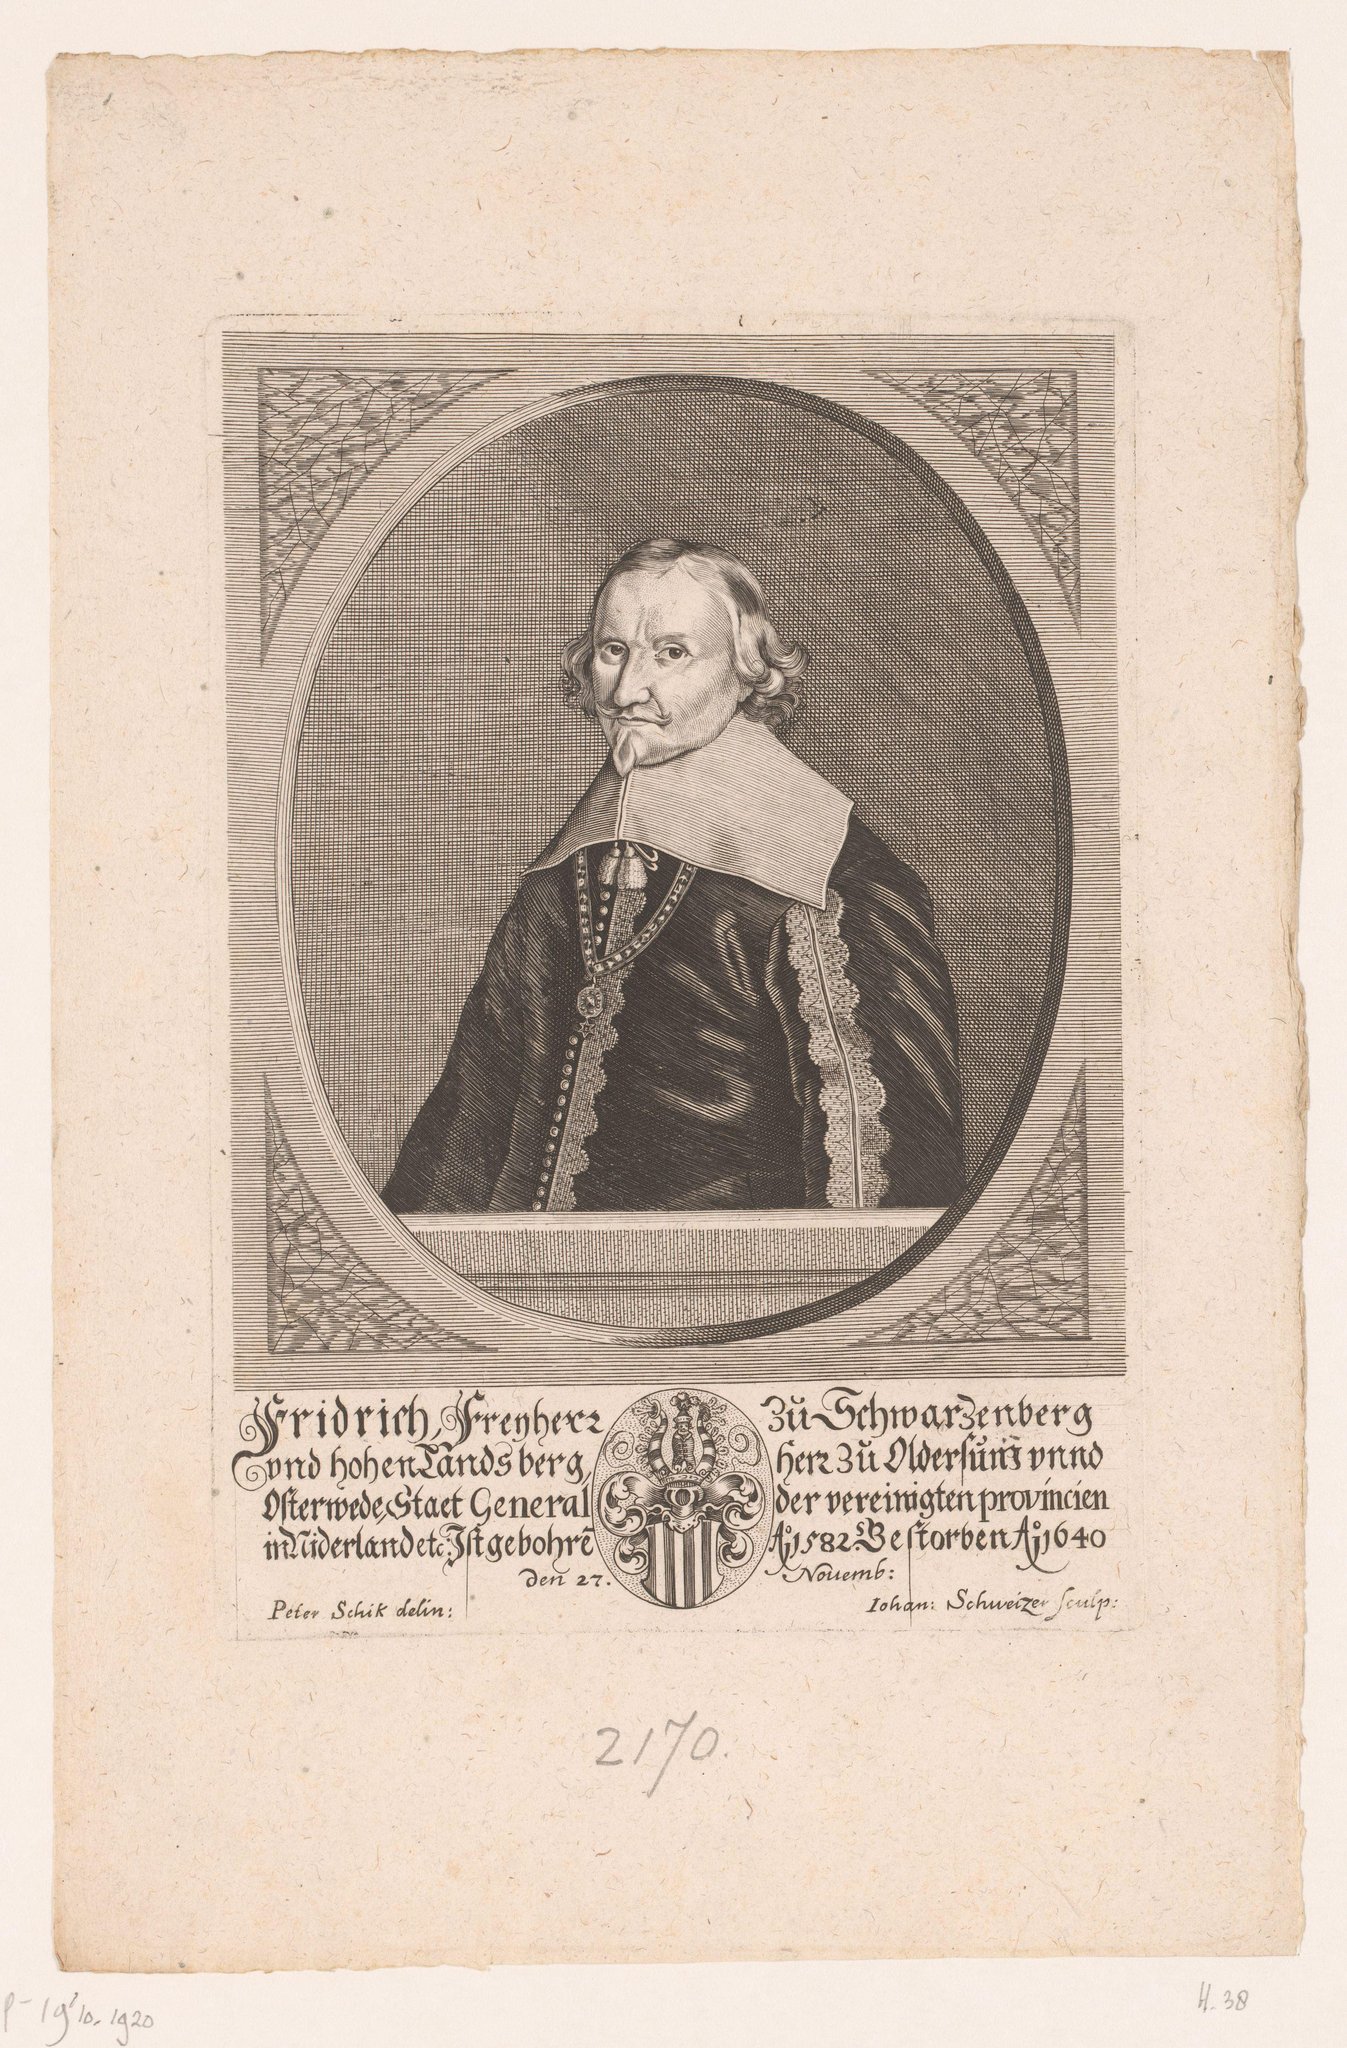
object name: print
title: Portret van Friedrich zu Schwarzenberg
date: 1640-1670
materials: paper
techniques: engraving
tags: earl, historical persons, armorial bearing, heraldry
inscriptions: collector's mark: Lugt 2228